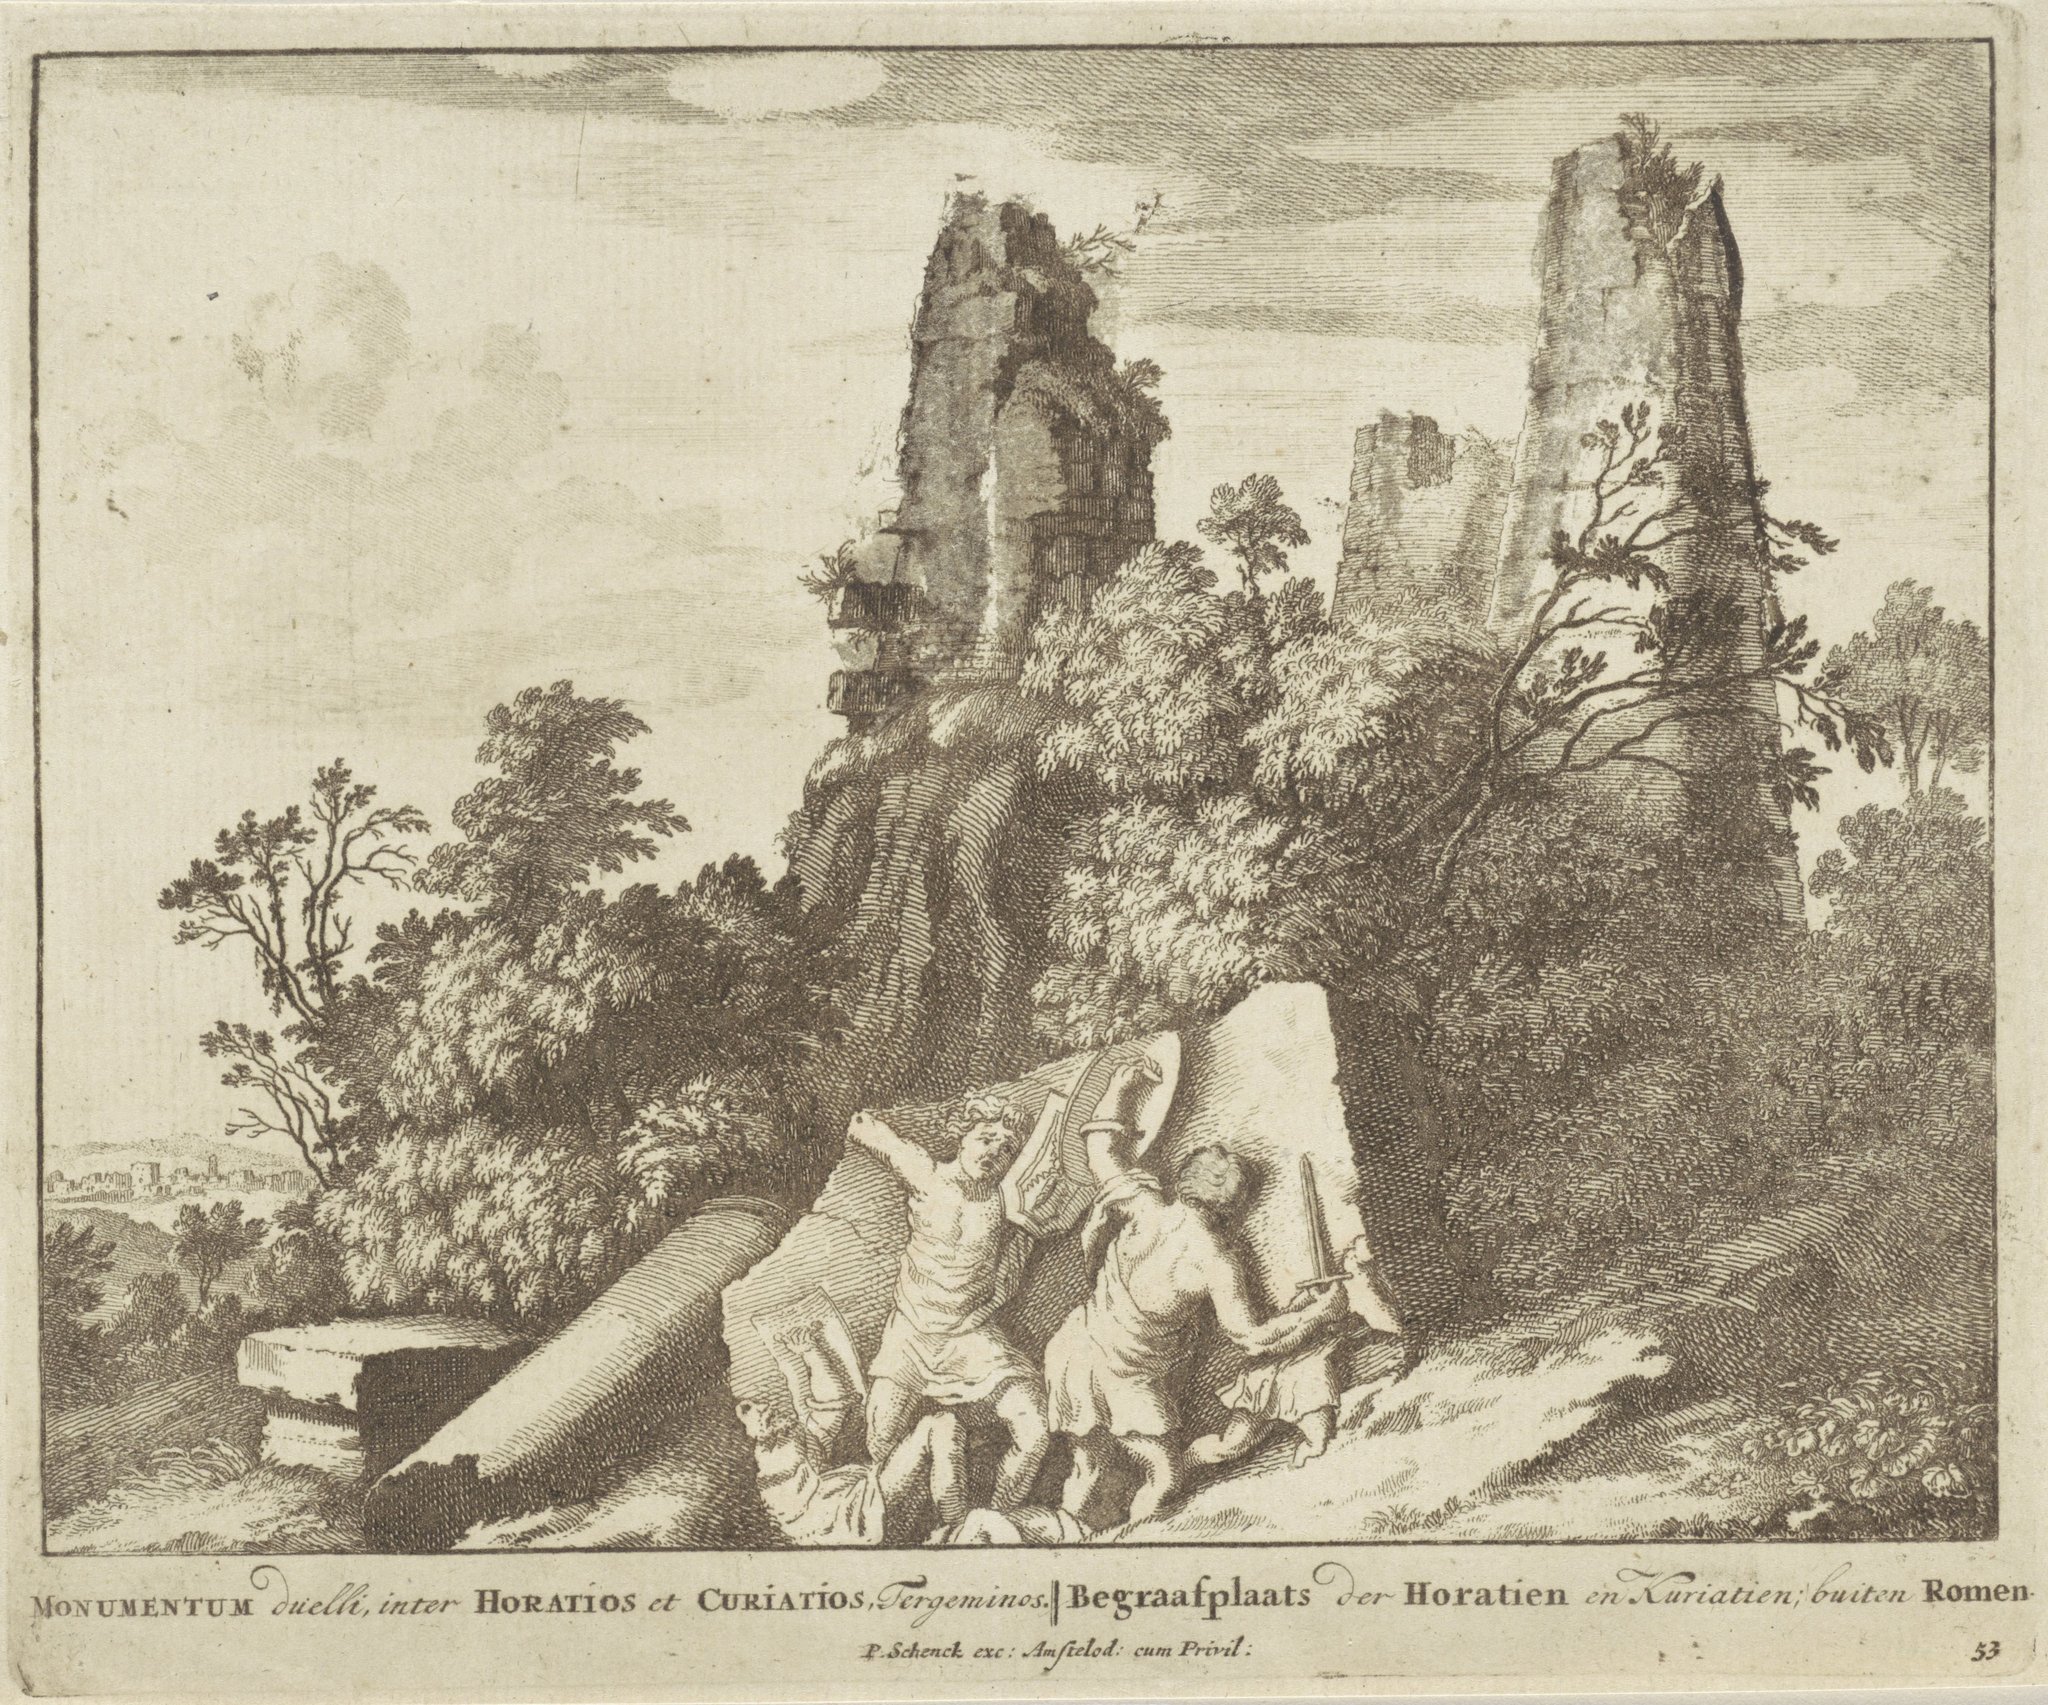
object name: print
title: Gezichten in Rome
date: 1675-1711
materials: paper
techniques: etching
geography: amsterdam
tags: churchyard, cemetery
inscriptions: collector's mark: Lugt 2228